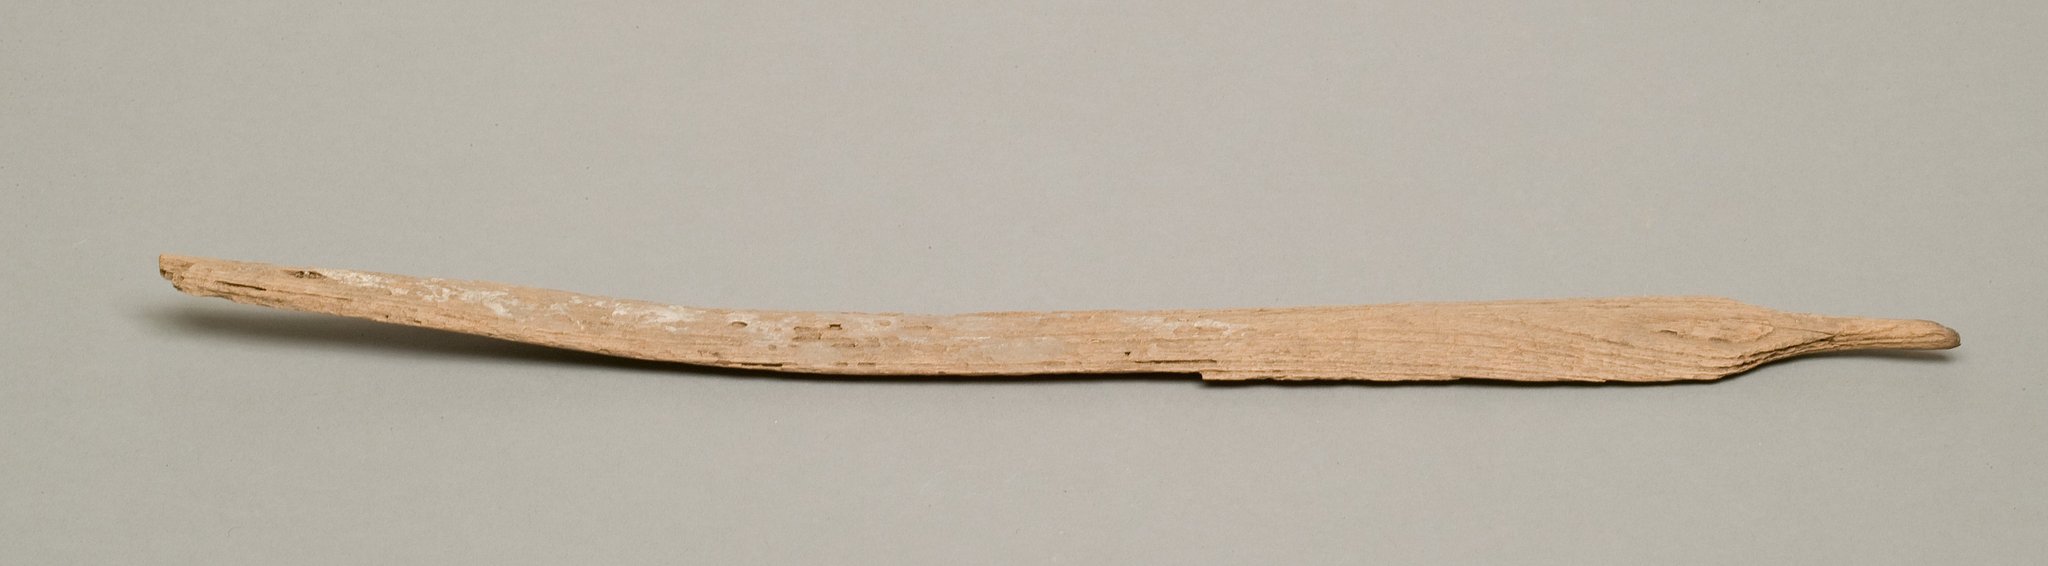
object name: weaving tool beater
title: Weaving tool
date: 1295-1070 BCE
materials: wood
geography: egypt